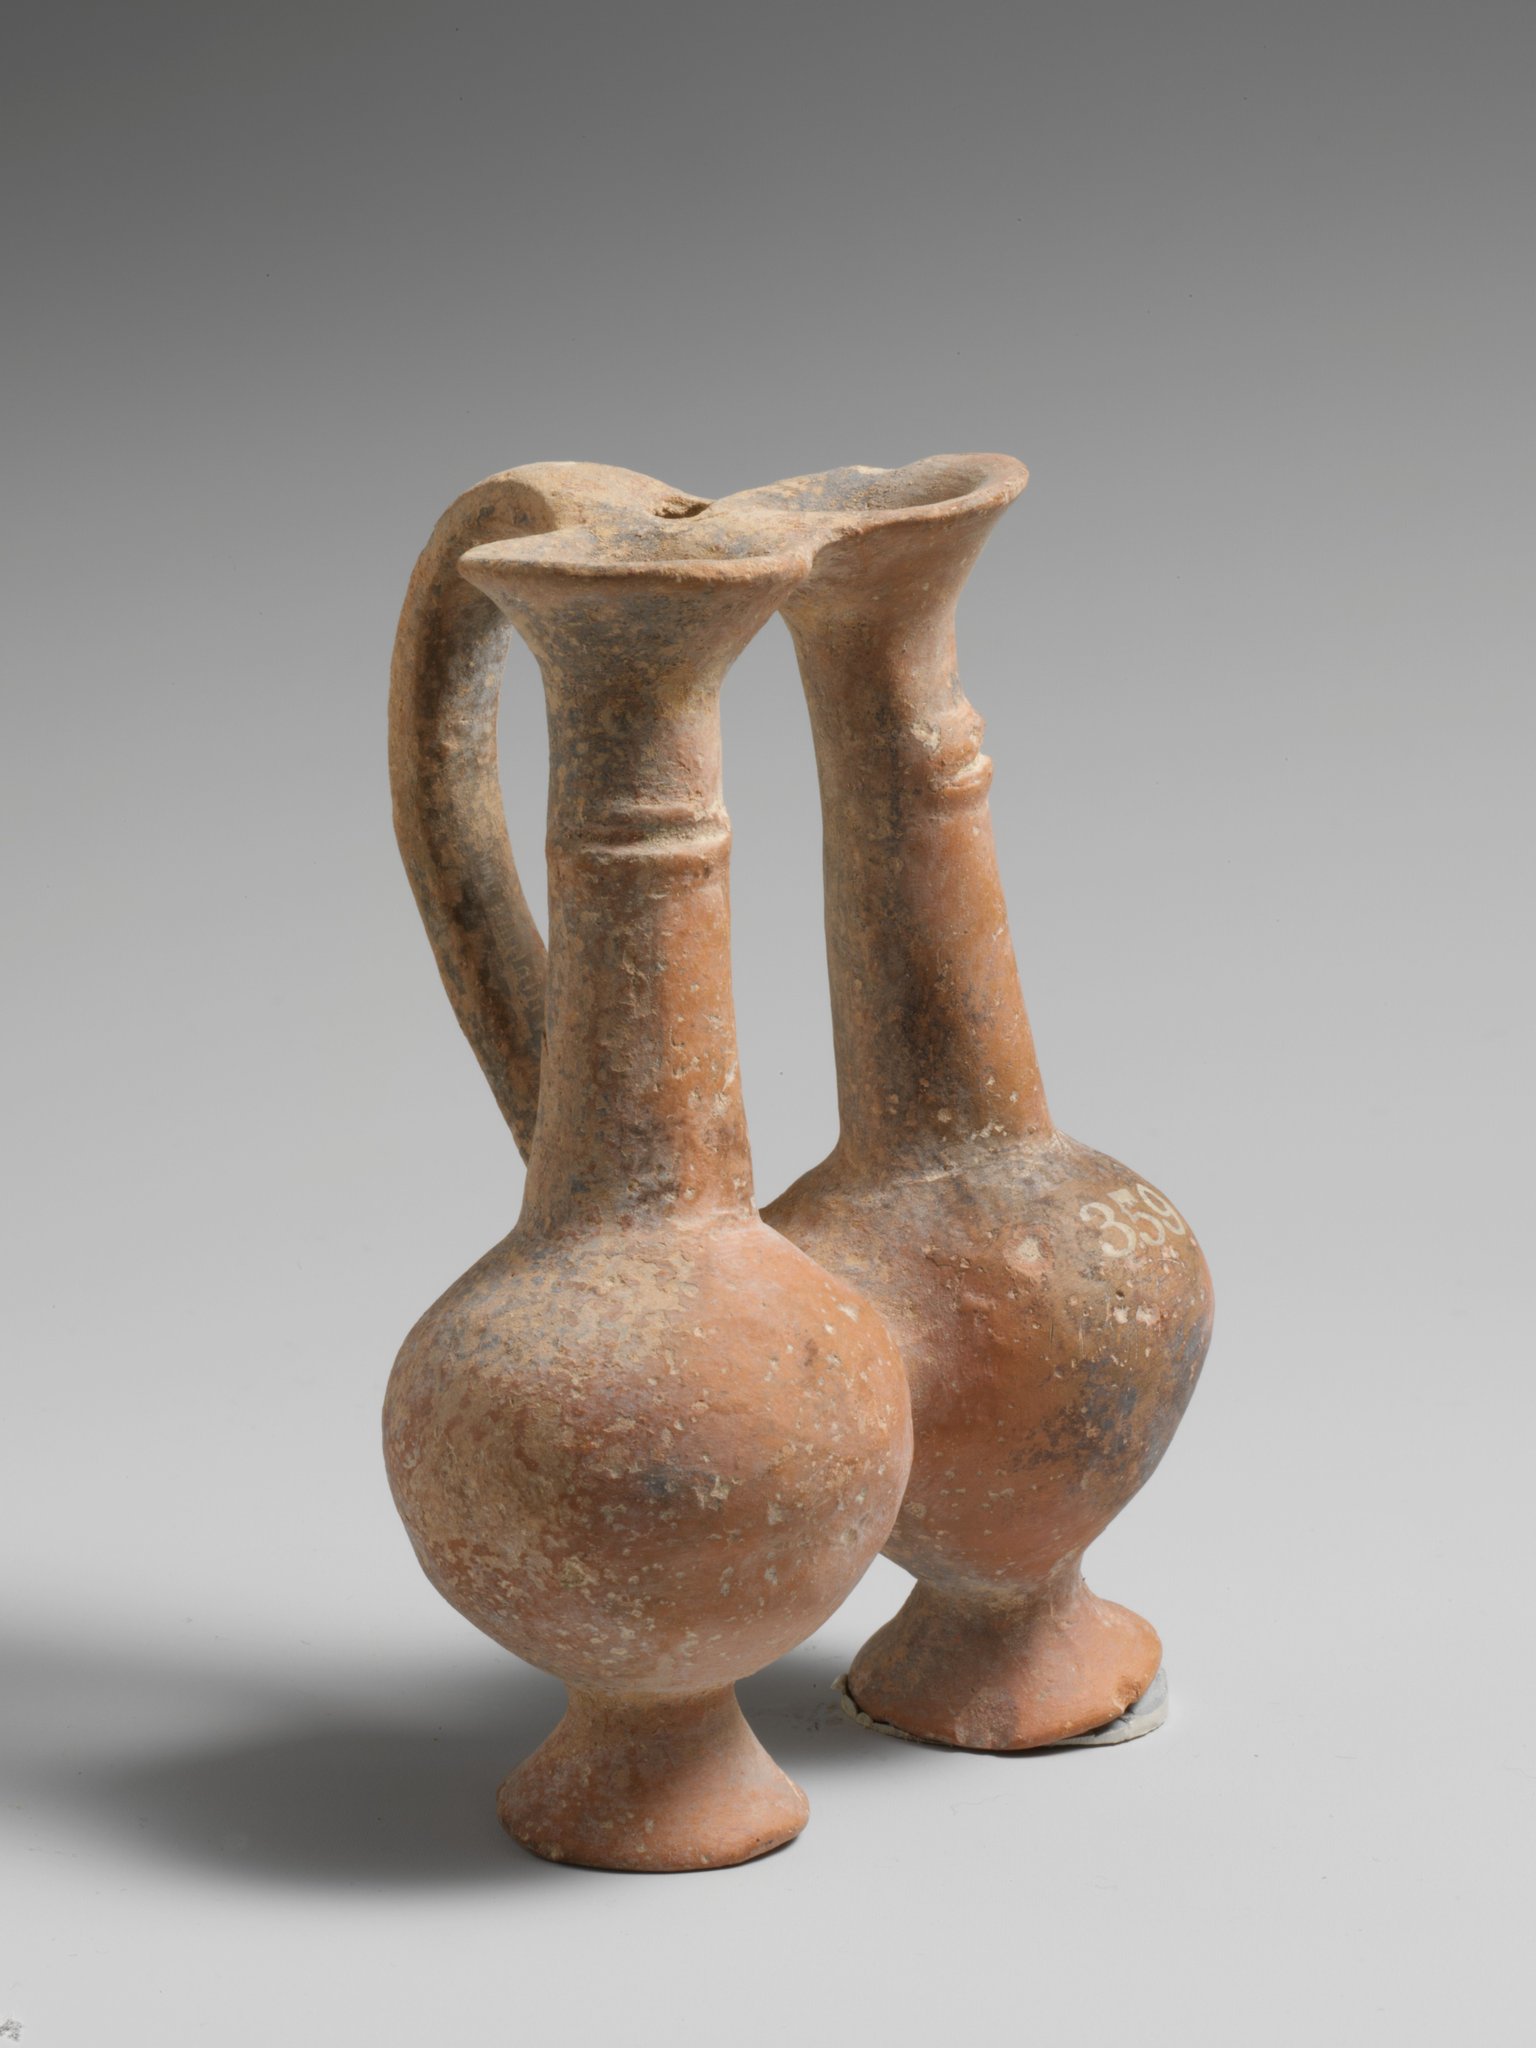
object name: bil bil, double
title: Terracotta bil-bil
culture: cypriot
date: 1600-1050 BCE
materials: terracotta